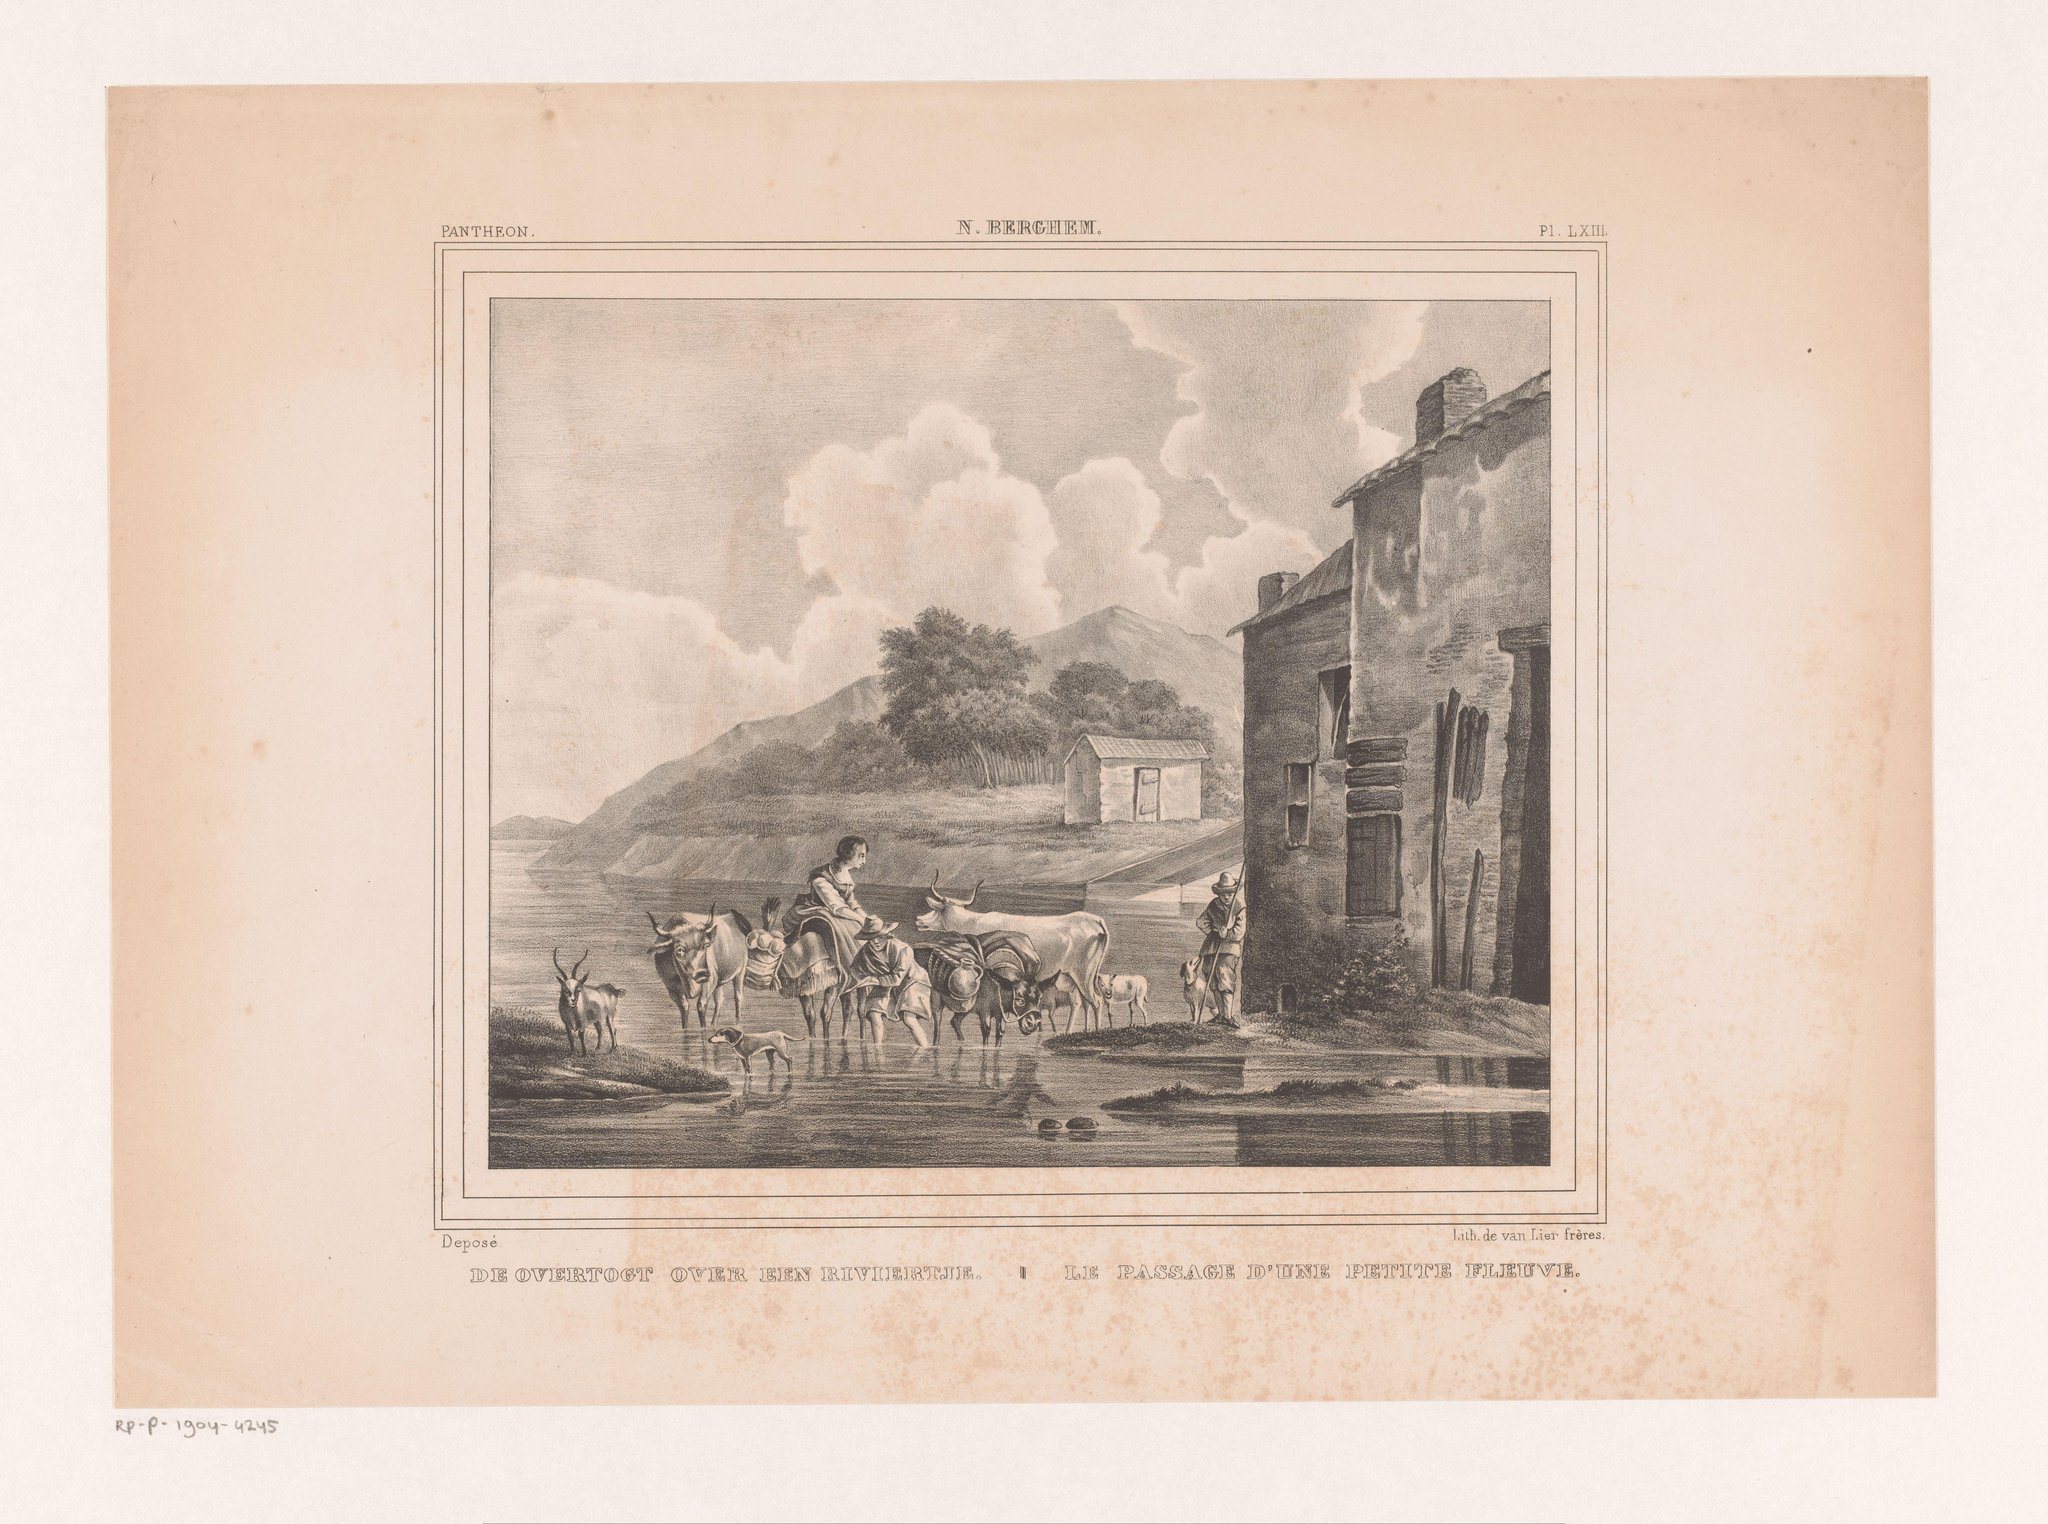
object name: print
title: Pantheon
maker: nicolaes pietersz berchem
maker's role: draughtsman, print maker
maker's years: 1620-1683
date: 1837-1843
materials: paper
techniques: lithograph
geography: the hague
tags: crossing a river, ass, donkey, cattle driving, cattle driver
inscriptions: : ‘Deposé’, collector's mark: Lugt 2228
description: Deze prent maakte mogelijk deel uit van: Pantheon of de tempel der onsterfelijkheid van Nederlandse kunstschilders. Uitgegeven door Gebroeders Van Lier in Amsterdam tussen 1837 en (in ieder geval) 1843.